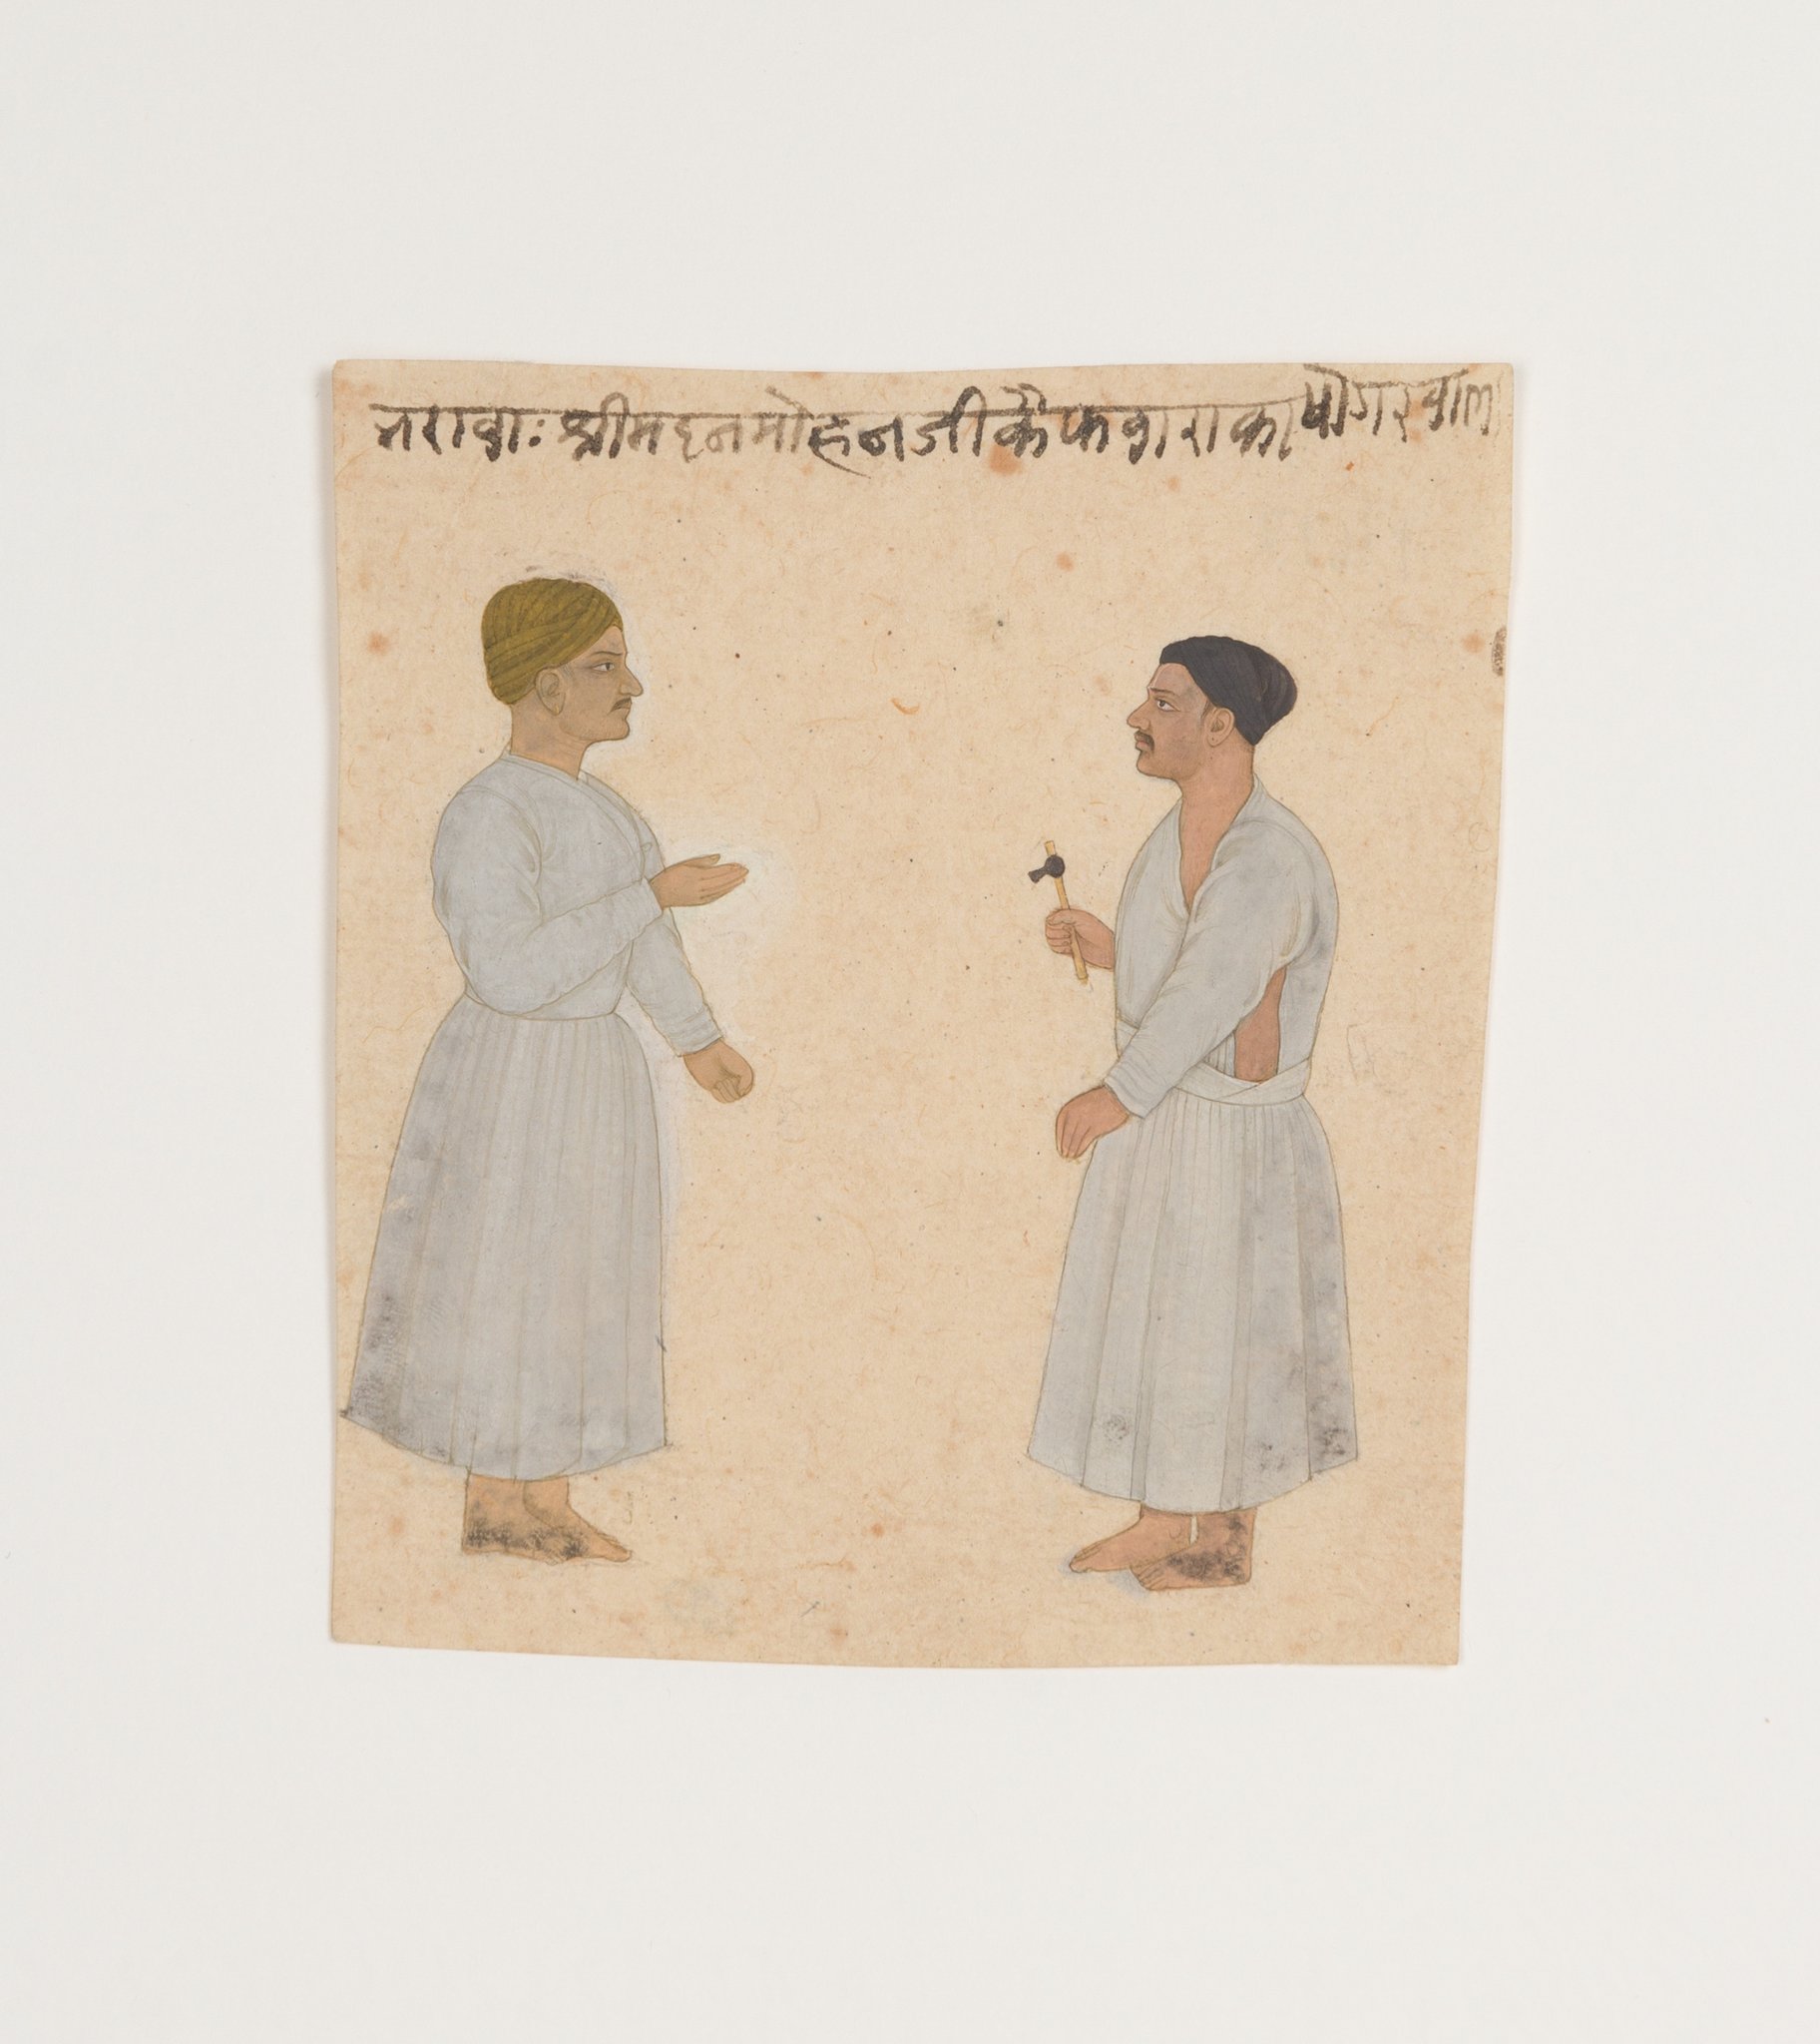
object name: painting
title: The Fountain Worker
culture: indian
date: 1801-1833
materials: ink, paper, watercolor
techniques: wash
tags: men